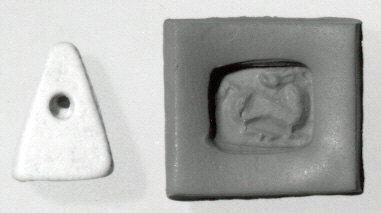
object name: stamp seal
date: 1000-1 BCE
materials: alabaster, gypsum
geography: central asia